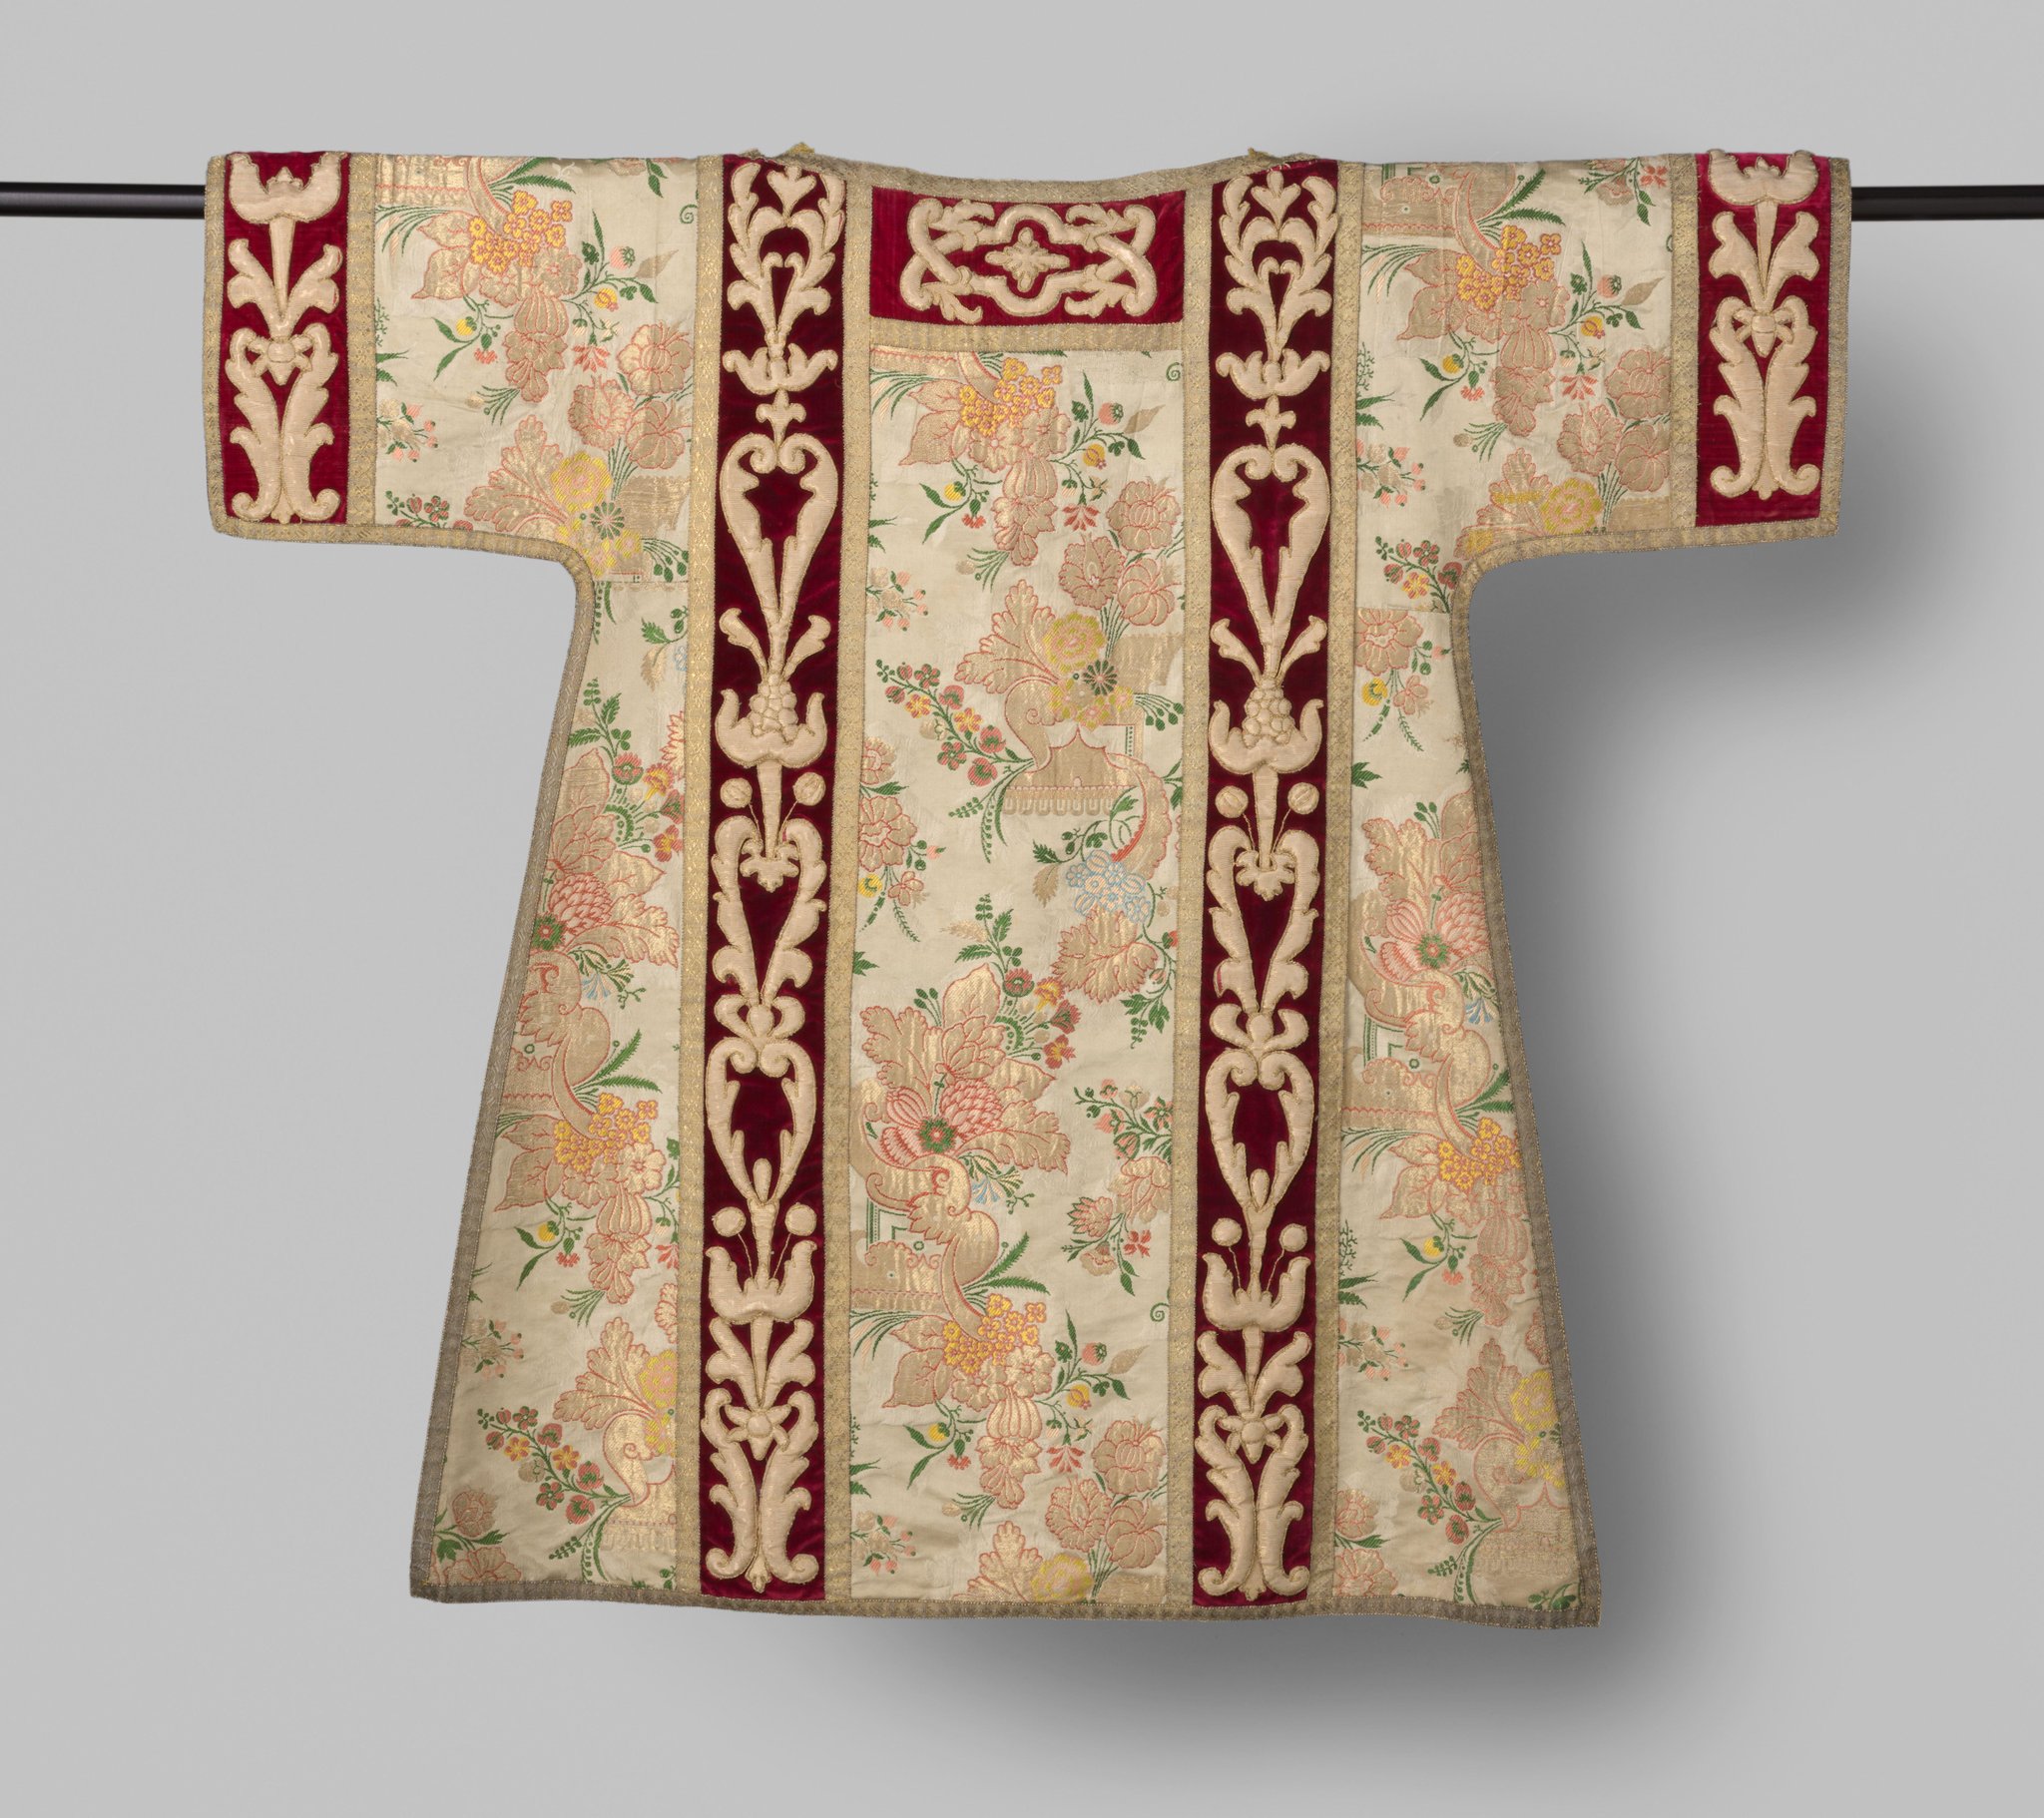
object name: dalmatic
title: Dalmatiek van goudbrokaat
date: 1700-1725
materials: textile, velvet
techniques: brocade, embroidered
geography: france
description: Dalmatiek met een aurifries en een praetext van geappliqueerd en opgevuld effen goudbrokaat. Bij de dalmatiek hoort een gelijke dalmatiek (BK-1972-1-D). Beide dalmatieken horen bij negen kerkelijke weefsels met borduurwerk met invnrs. BK-1972-1-A t/m BK-1972-1-I en een niet bijbehorende beurs met invnr. BK-1972-1-J.